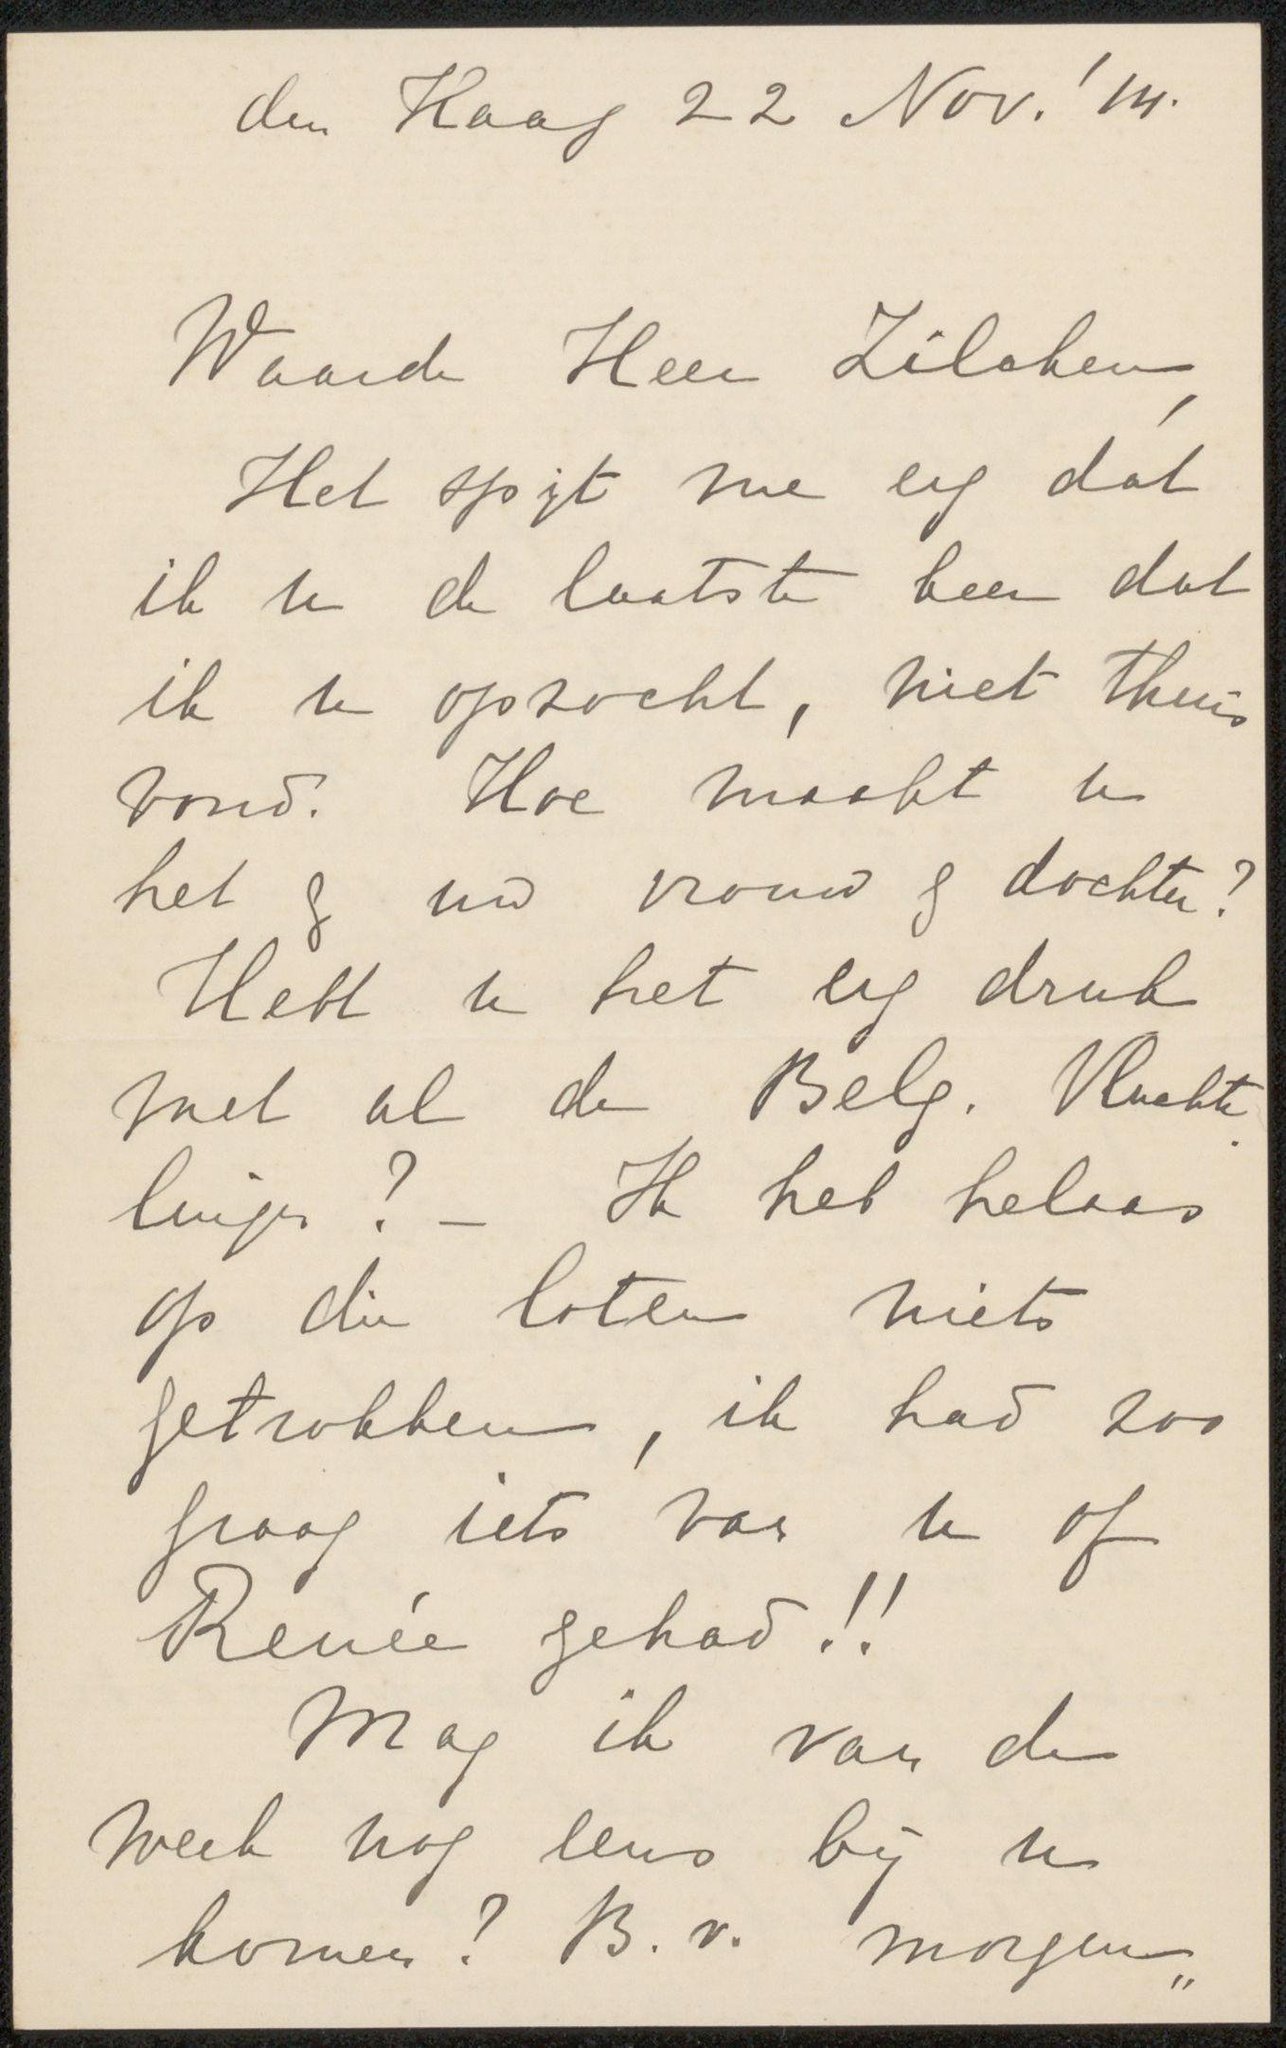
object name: letter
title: Brief aan Philip Zilcken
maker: fenna de meyier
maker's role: onderwijzer, schrijver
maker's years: 1874-1943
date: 1914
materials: ink, paper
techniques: pen, writing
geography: the hague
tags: paris, etienne dinet, painter, draughtsman, philip zilcken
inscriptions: watermark, collector's mark: ‘RPK’